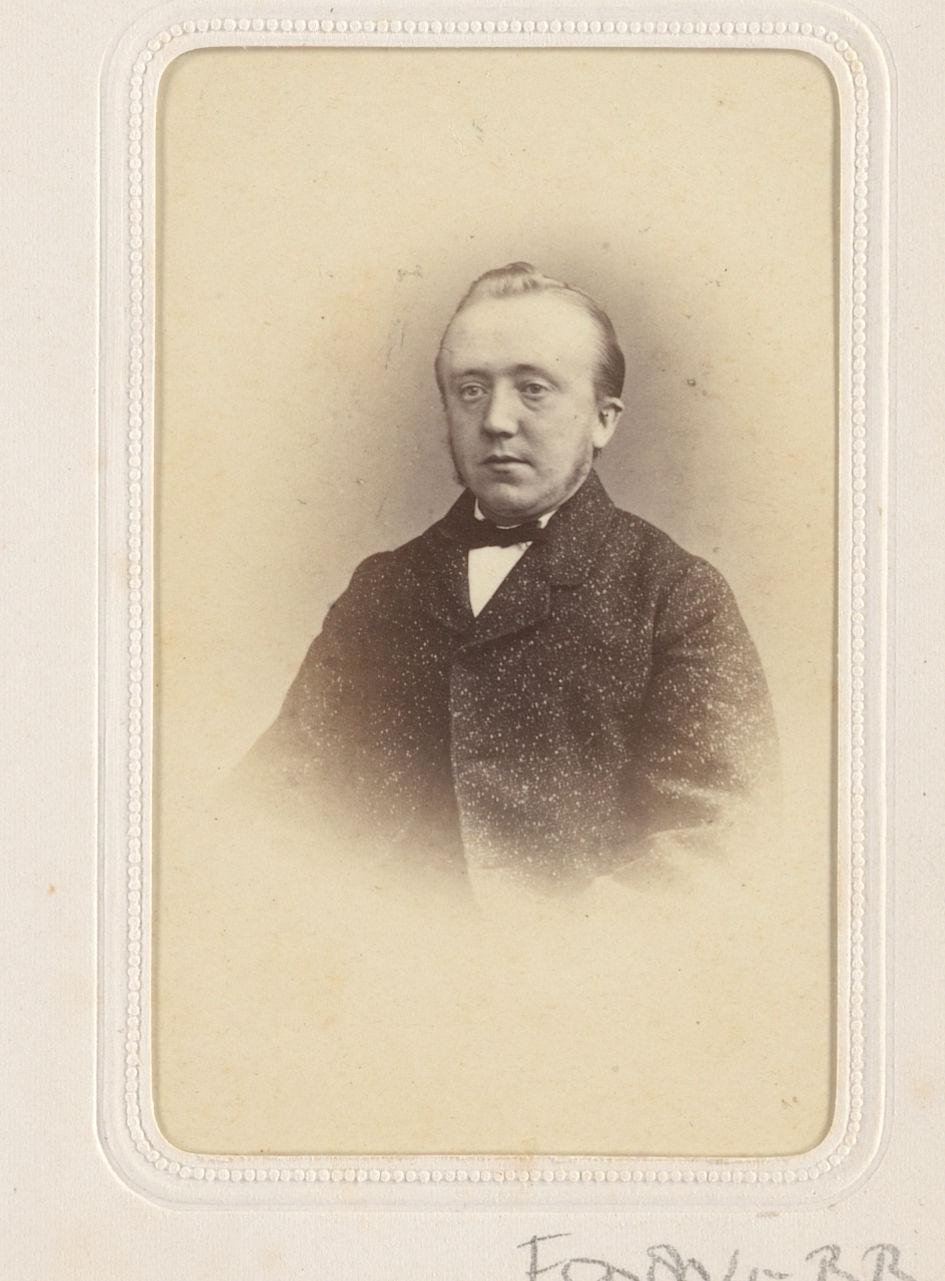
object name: album leaf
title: Portret van een man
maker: charles binger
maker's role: print maker, printer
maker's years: 1830-1916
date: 1862-1869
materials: cardboard, photographic support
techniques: albumen print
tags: adult man, historical persons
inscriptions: inscription: ‘CH. Binger & Co/ Photographische Inrigting/ Zijlstraat/ Haarlem’